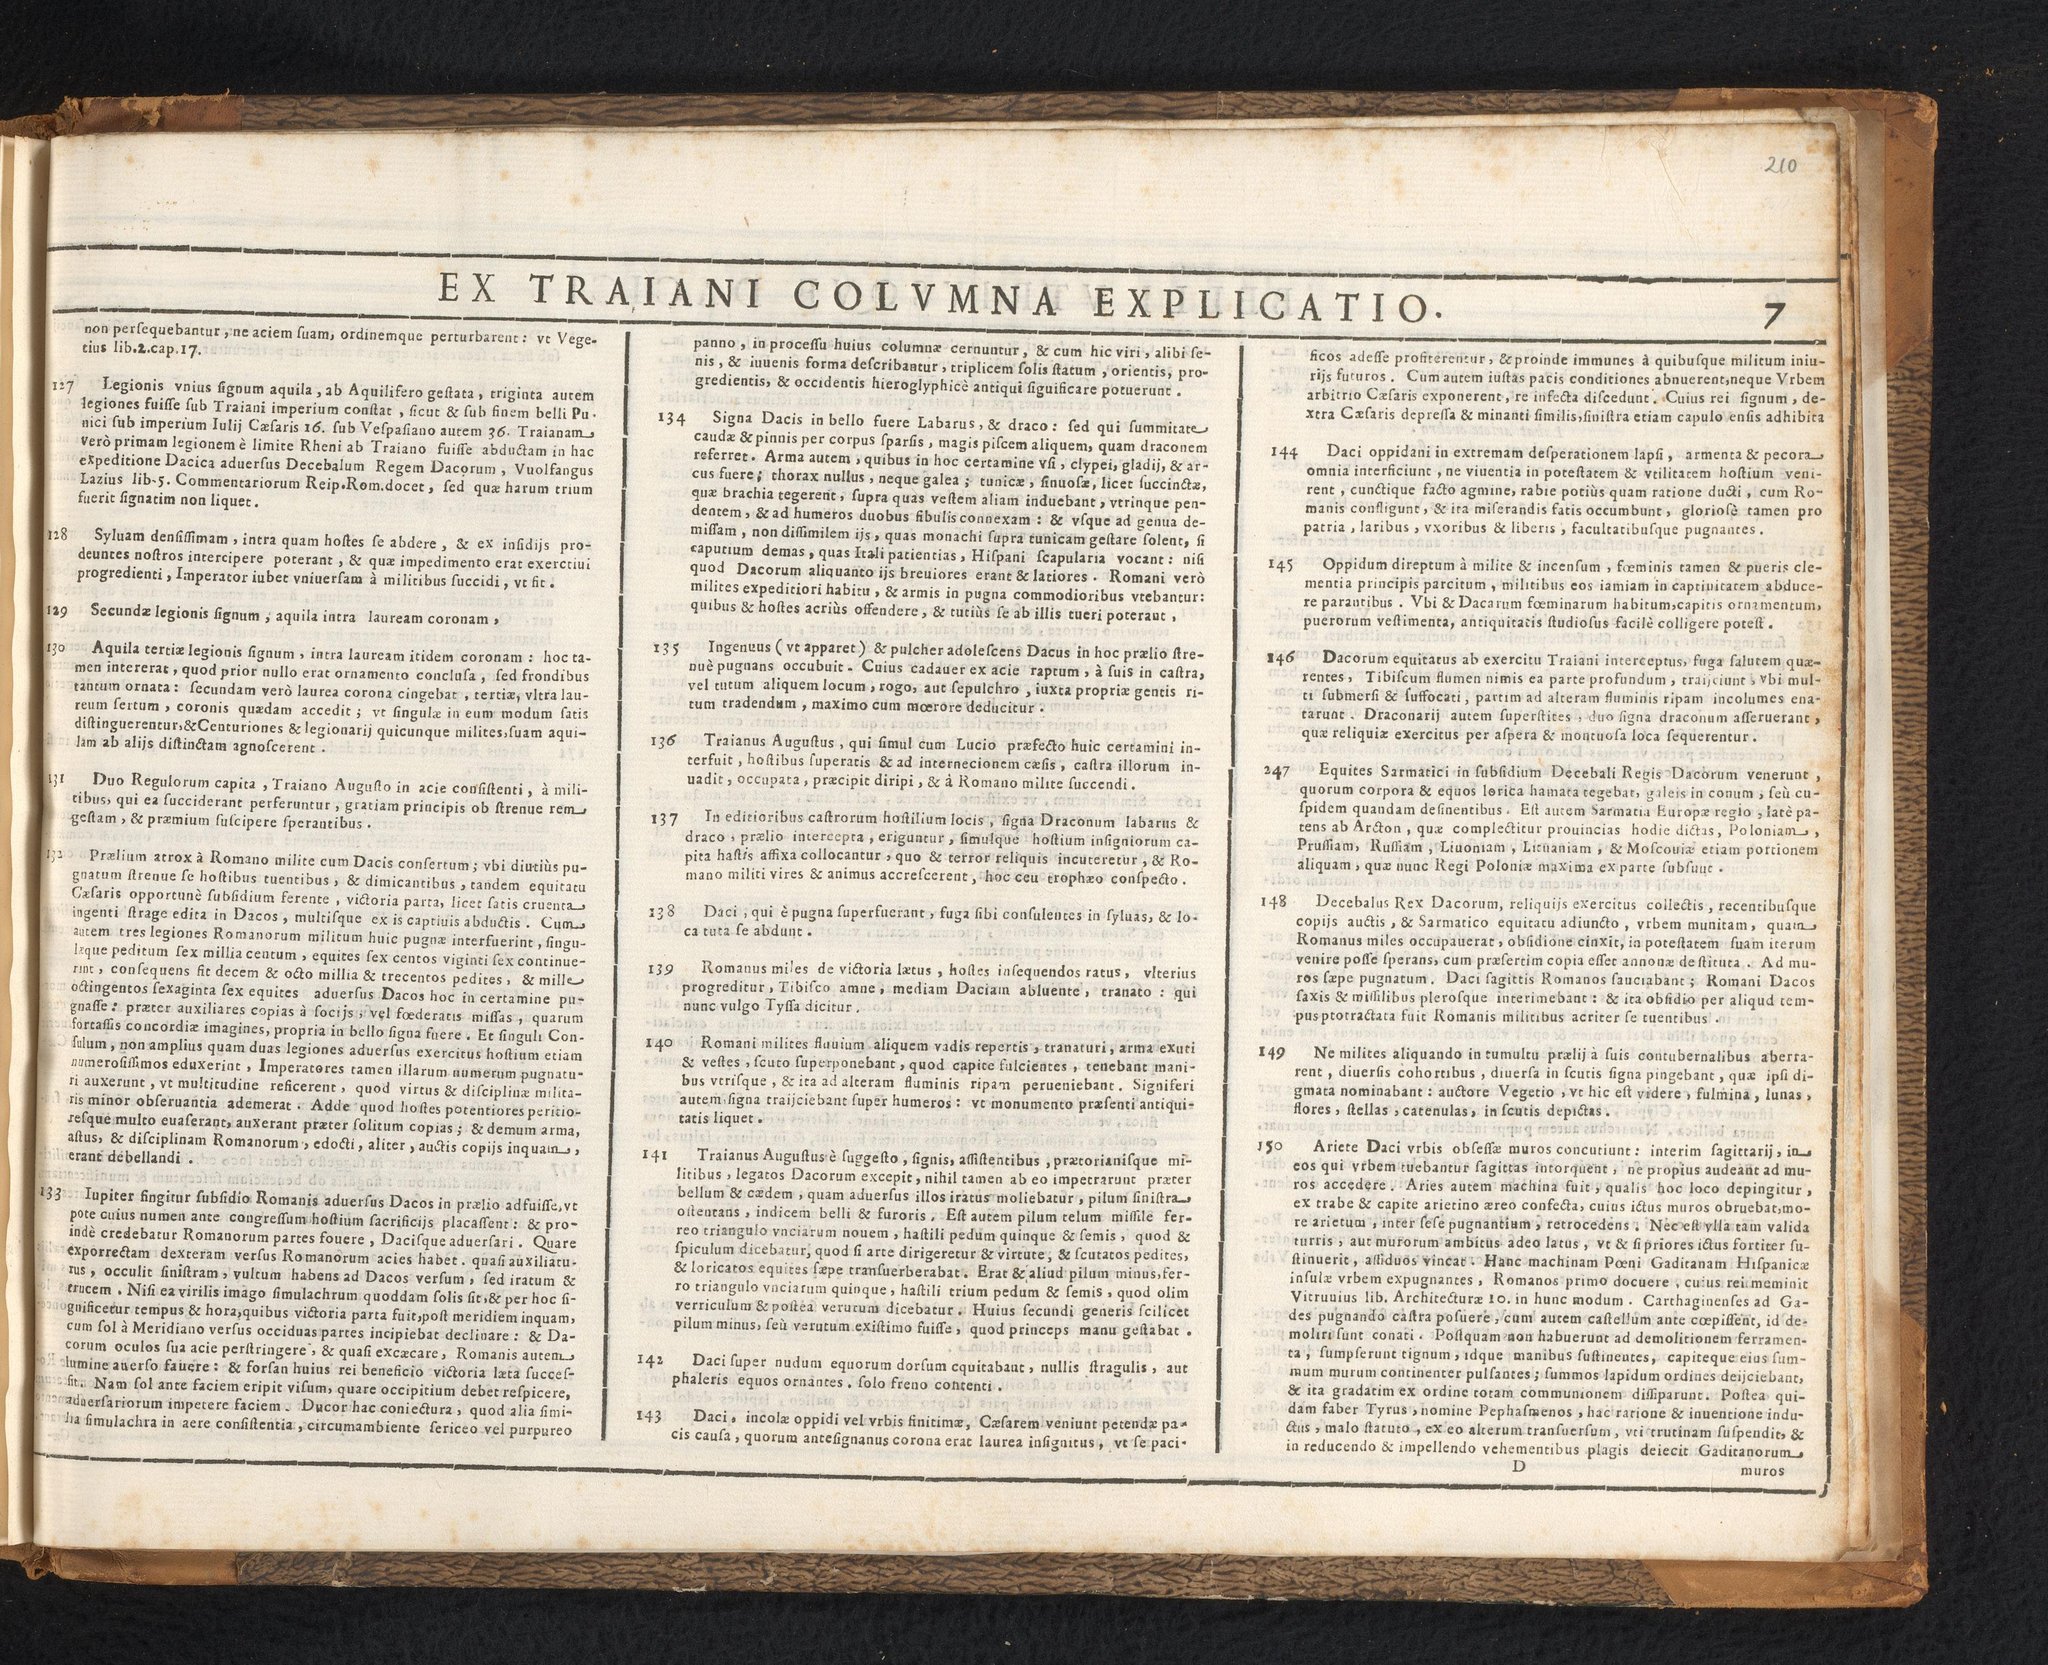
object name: text sheet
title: Beschrijving van de scènes op de Zuil van Trajanus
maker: Anonymous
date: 1550-1599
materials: paper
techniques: letterpress printing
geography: italy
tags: zuil van trajanus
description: Een beschrijving van scènes 127 tot en met 150 op de Zuil van Trajanus, in het Italiaans. Prent maakt deel uit van een album.